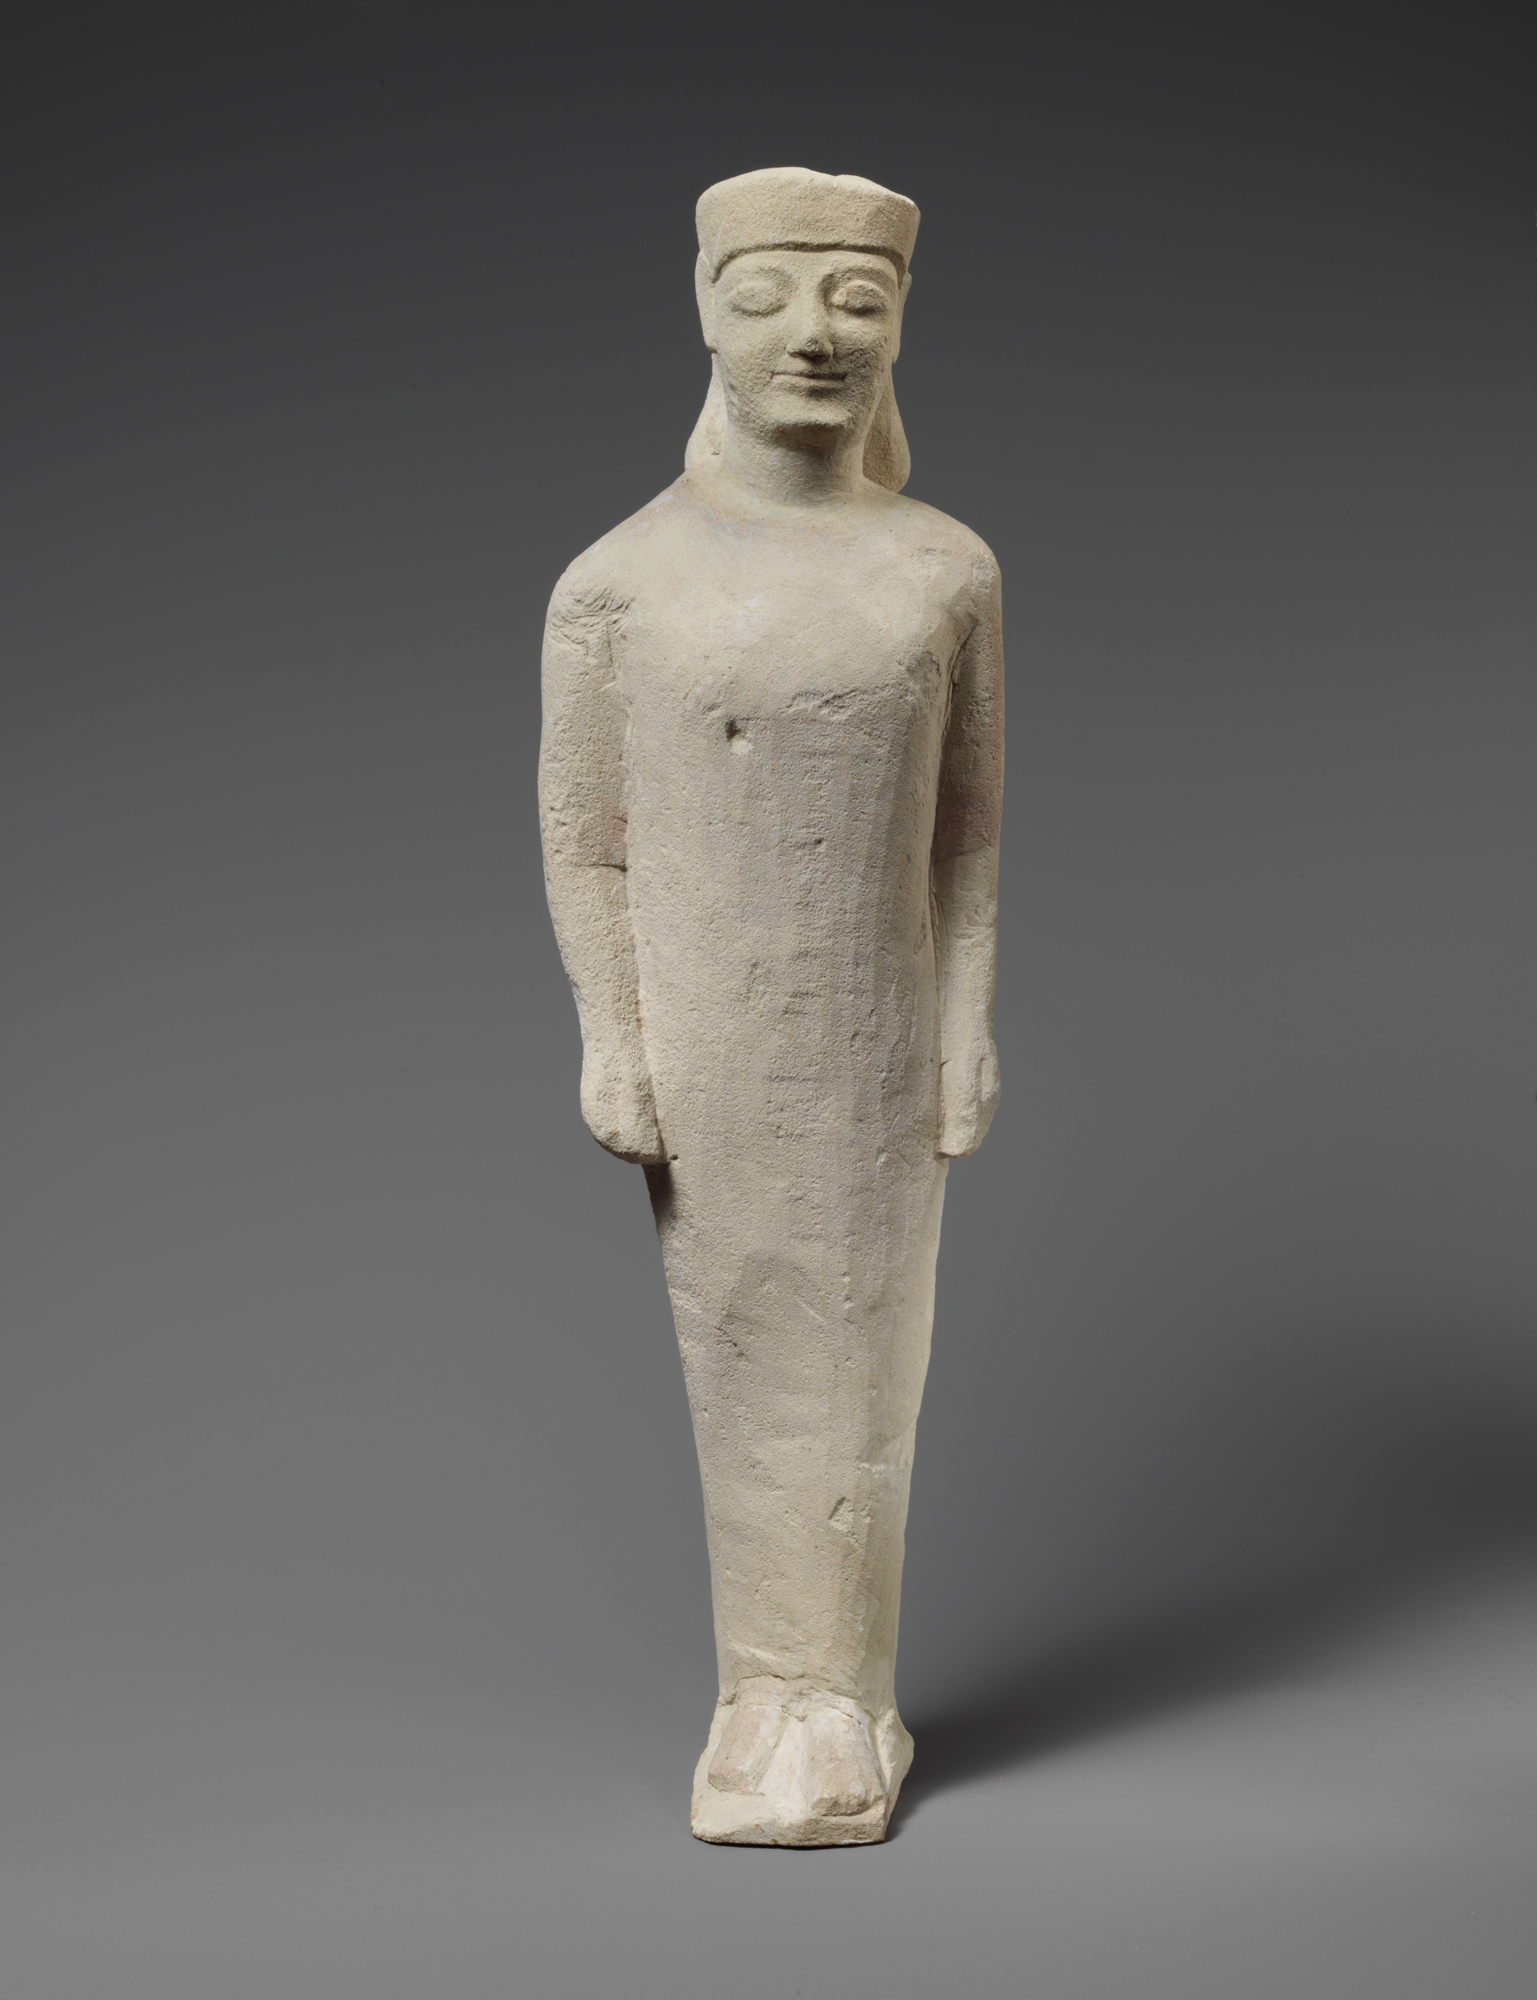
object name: statue of a votary, male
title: Limestone statuette of a beardless male votary in Greek dress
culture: cypriot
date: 600-501 BCE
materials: limestone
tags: men